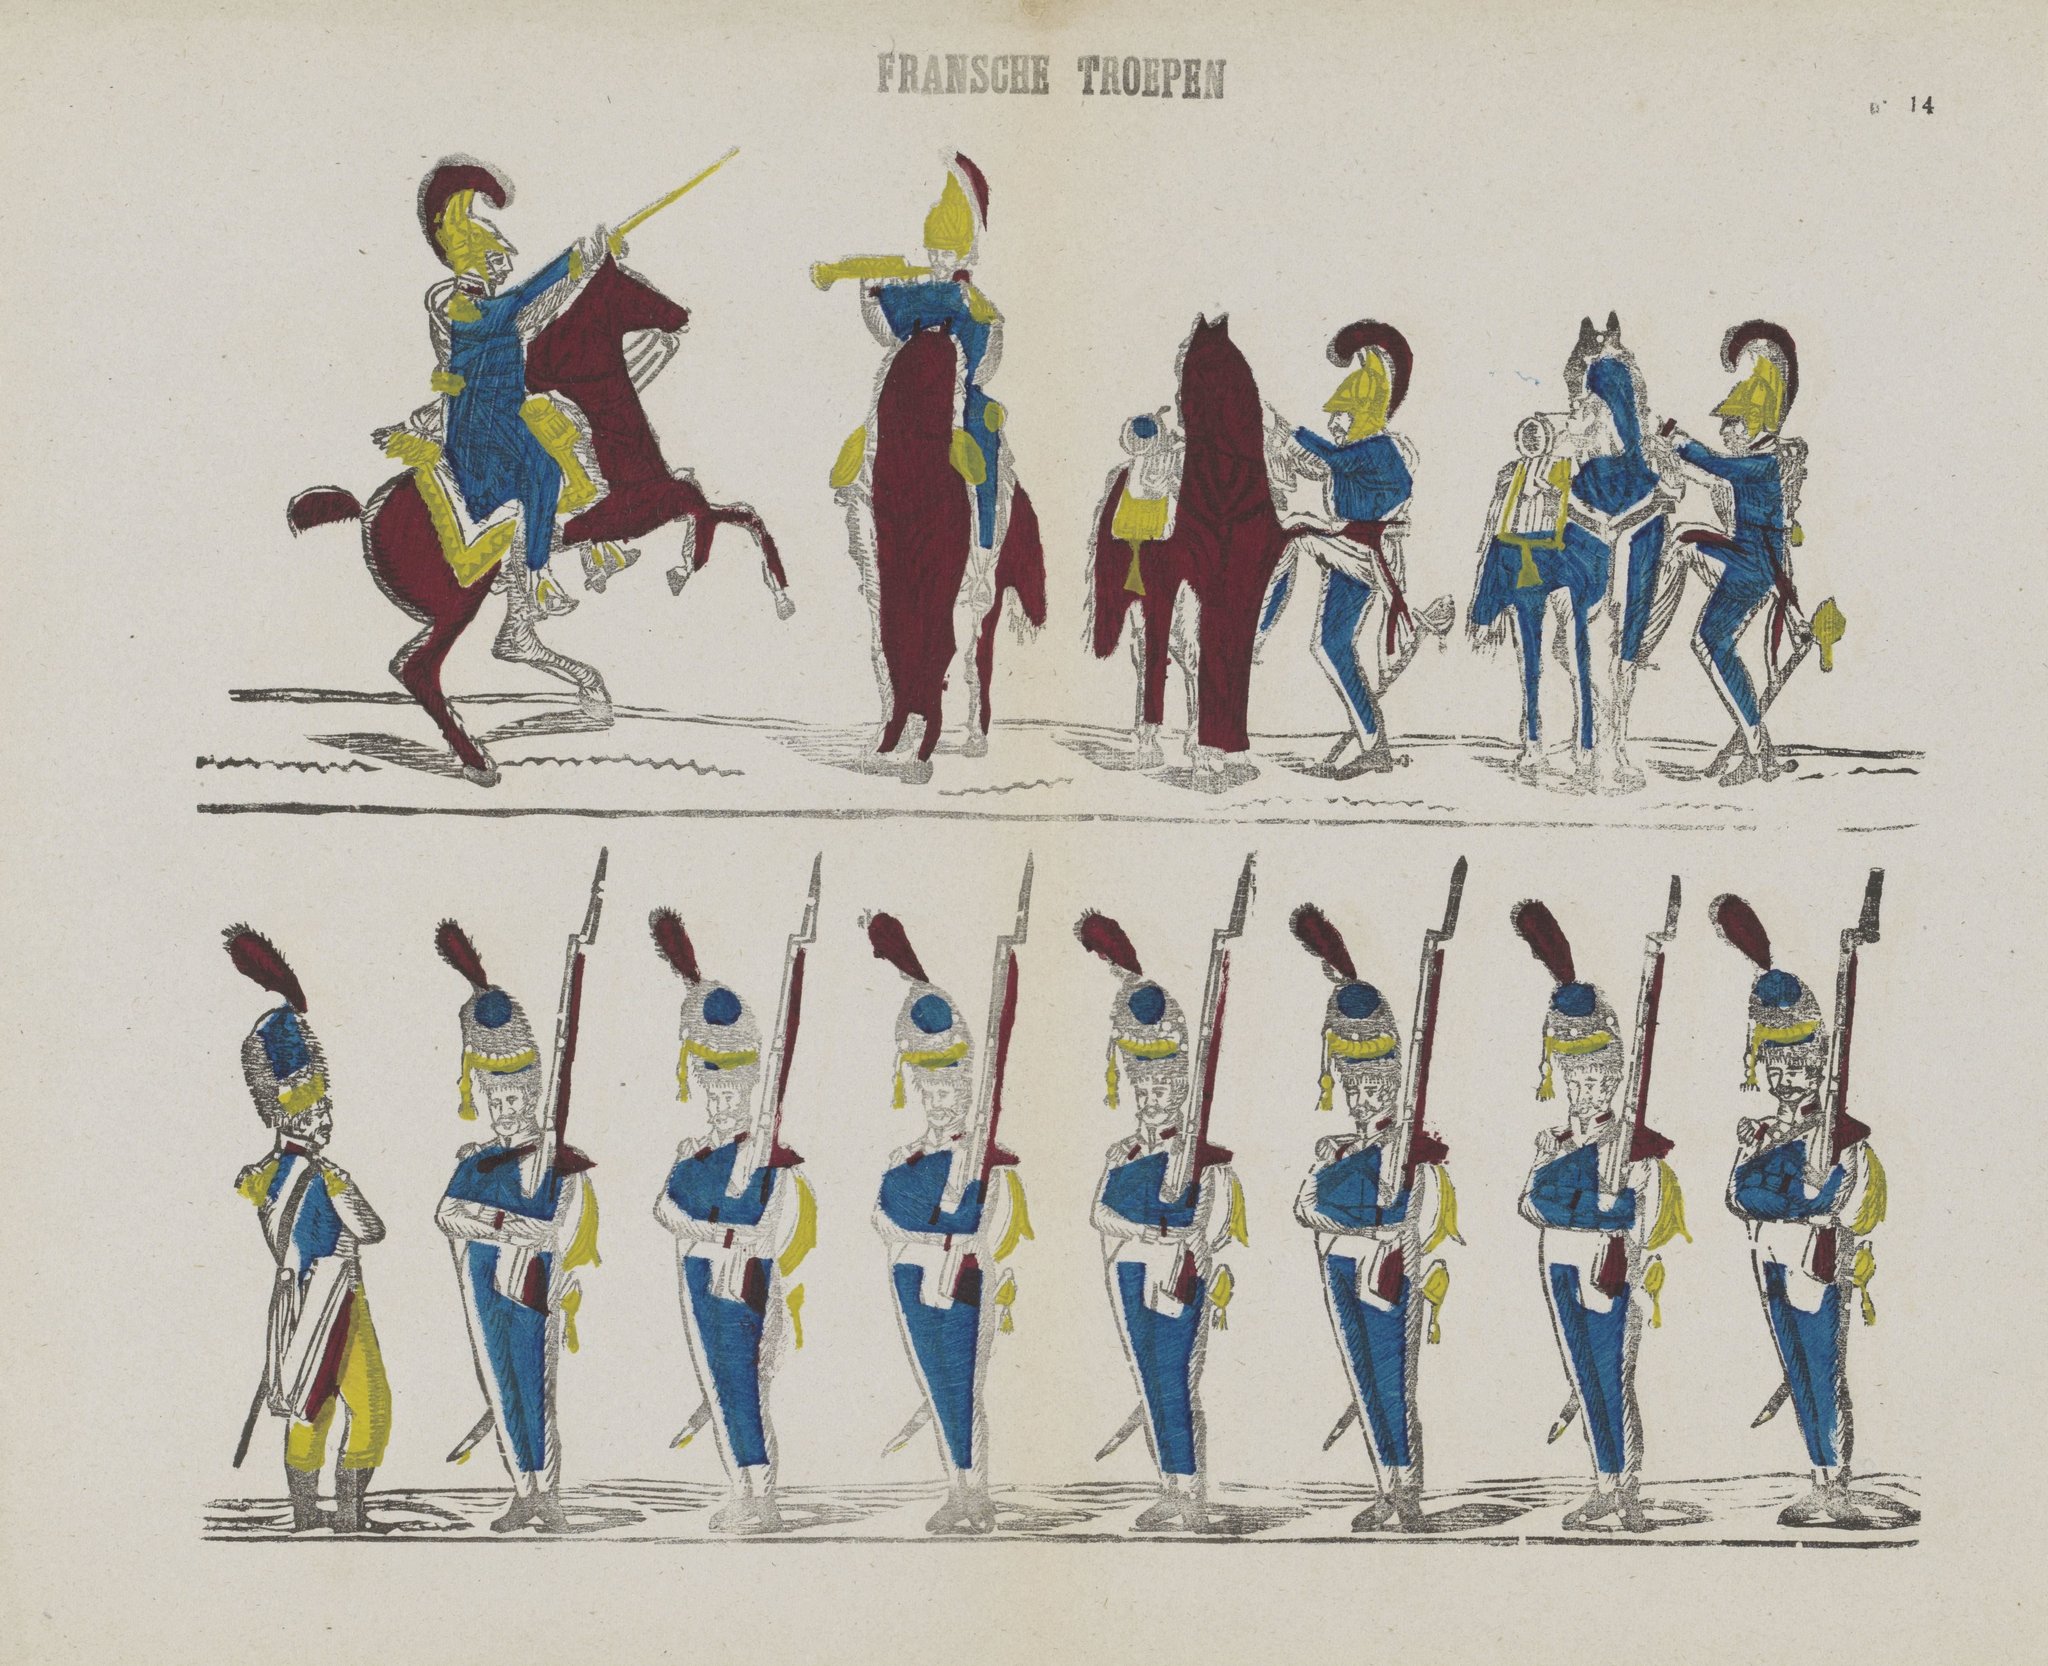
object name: print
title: Fransche troepen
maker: Anonymous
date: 1848-1881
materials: paper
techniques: colour, letterpress printing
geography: netherlands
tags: warfare; military affairs (+ cavalry, horsemen), the soldier; the soldier's life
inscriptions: collector's mark: Lugt 2760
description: Blad met 2 horizontale rijen met voorstellingen van Franse militairen. Genummerd rechtsboven: no 14.